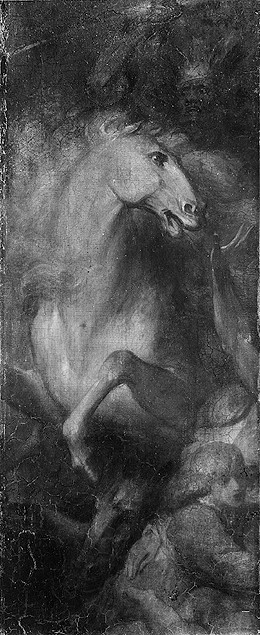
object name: painting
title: Benjamin West (fragment from a portrait)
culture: american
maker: james green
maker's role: artist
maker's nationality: british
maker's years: 1771-1834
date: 1818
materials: canvas, oil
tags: men,horses